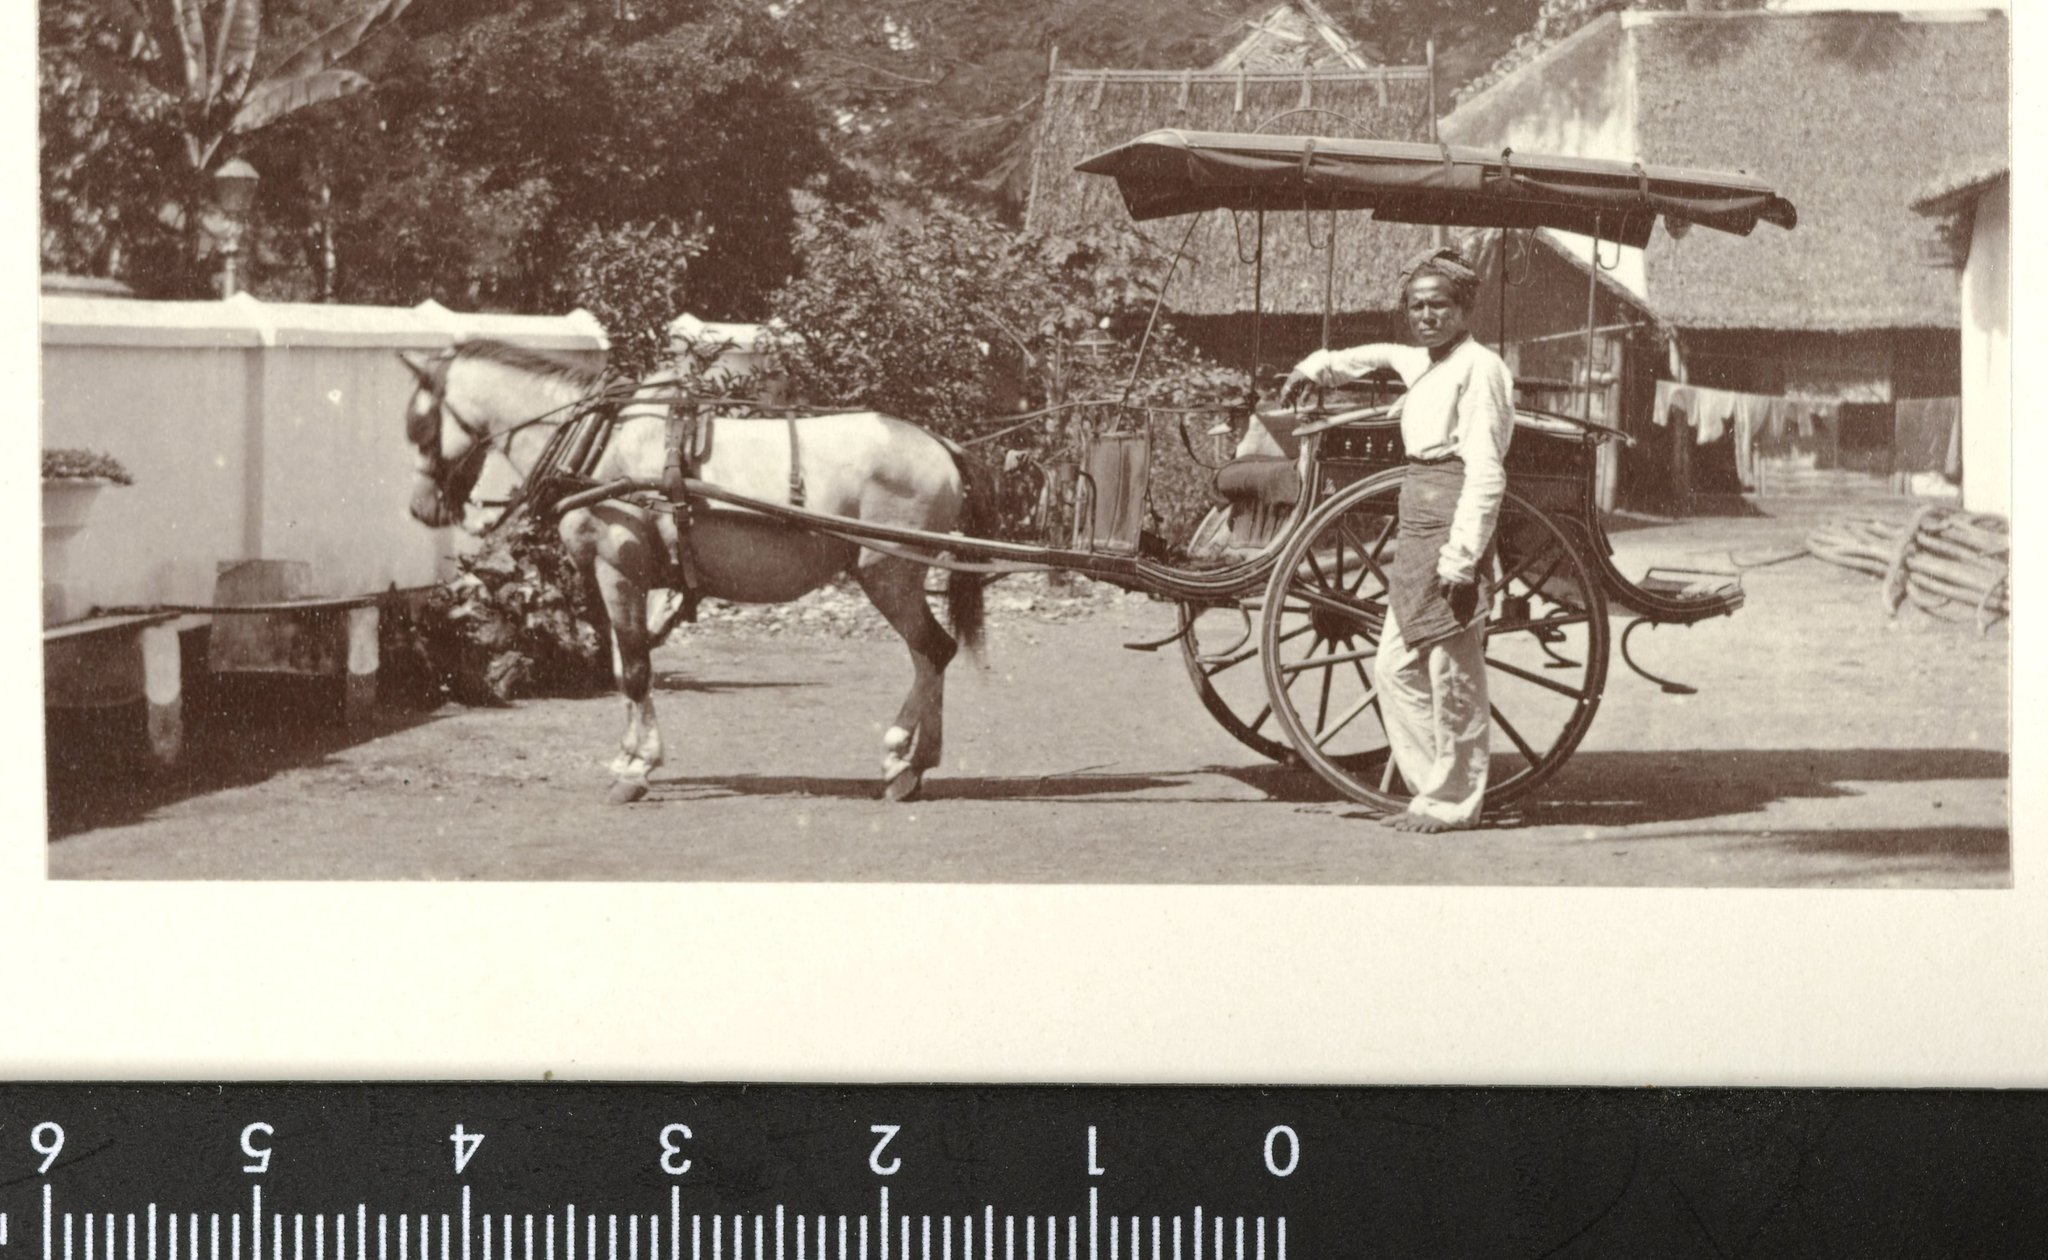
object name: photograph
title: Koetsier met rijtuig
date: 1860-1880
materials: photographic support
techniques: albumen print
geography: batavia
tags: two-wheeled vehicle drawn by one animal, java, batavia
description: Een koetsier staande voor zijn rijtuig, waarschijnlijk in Batavia. Ingeplakte foto in het fotoalbum getiteld: Gezichten van Java.